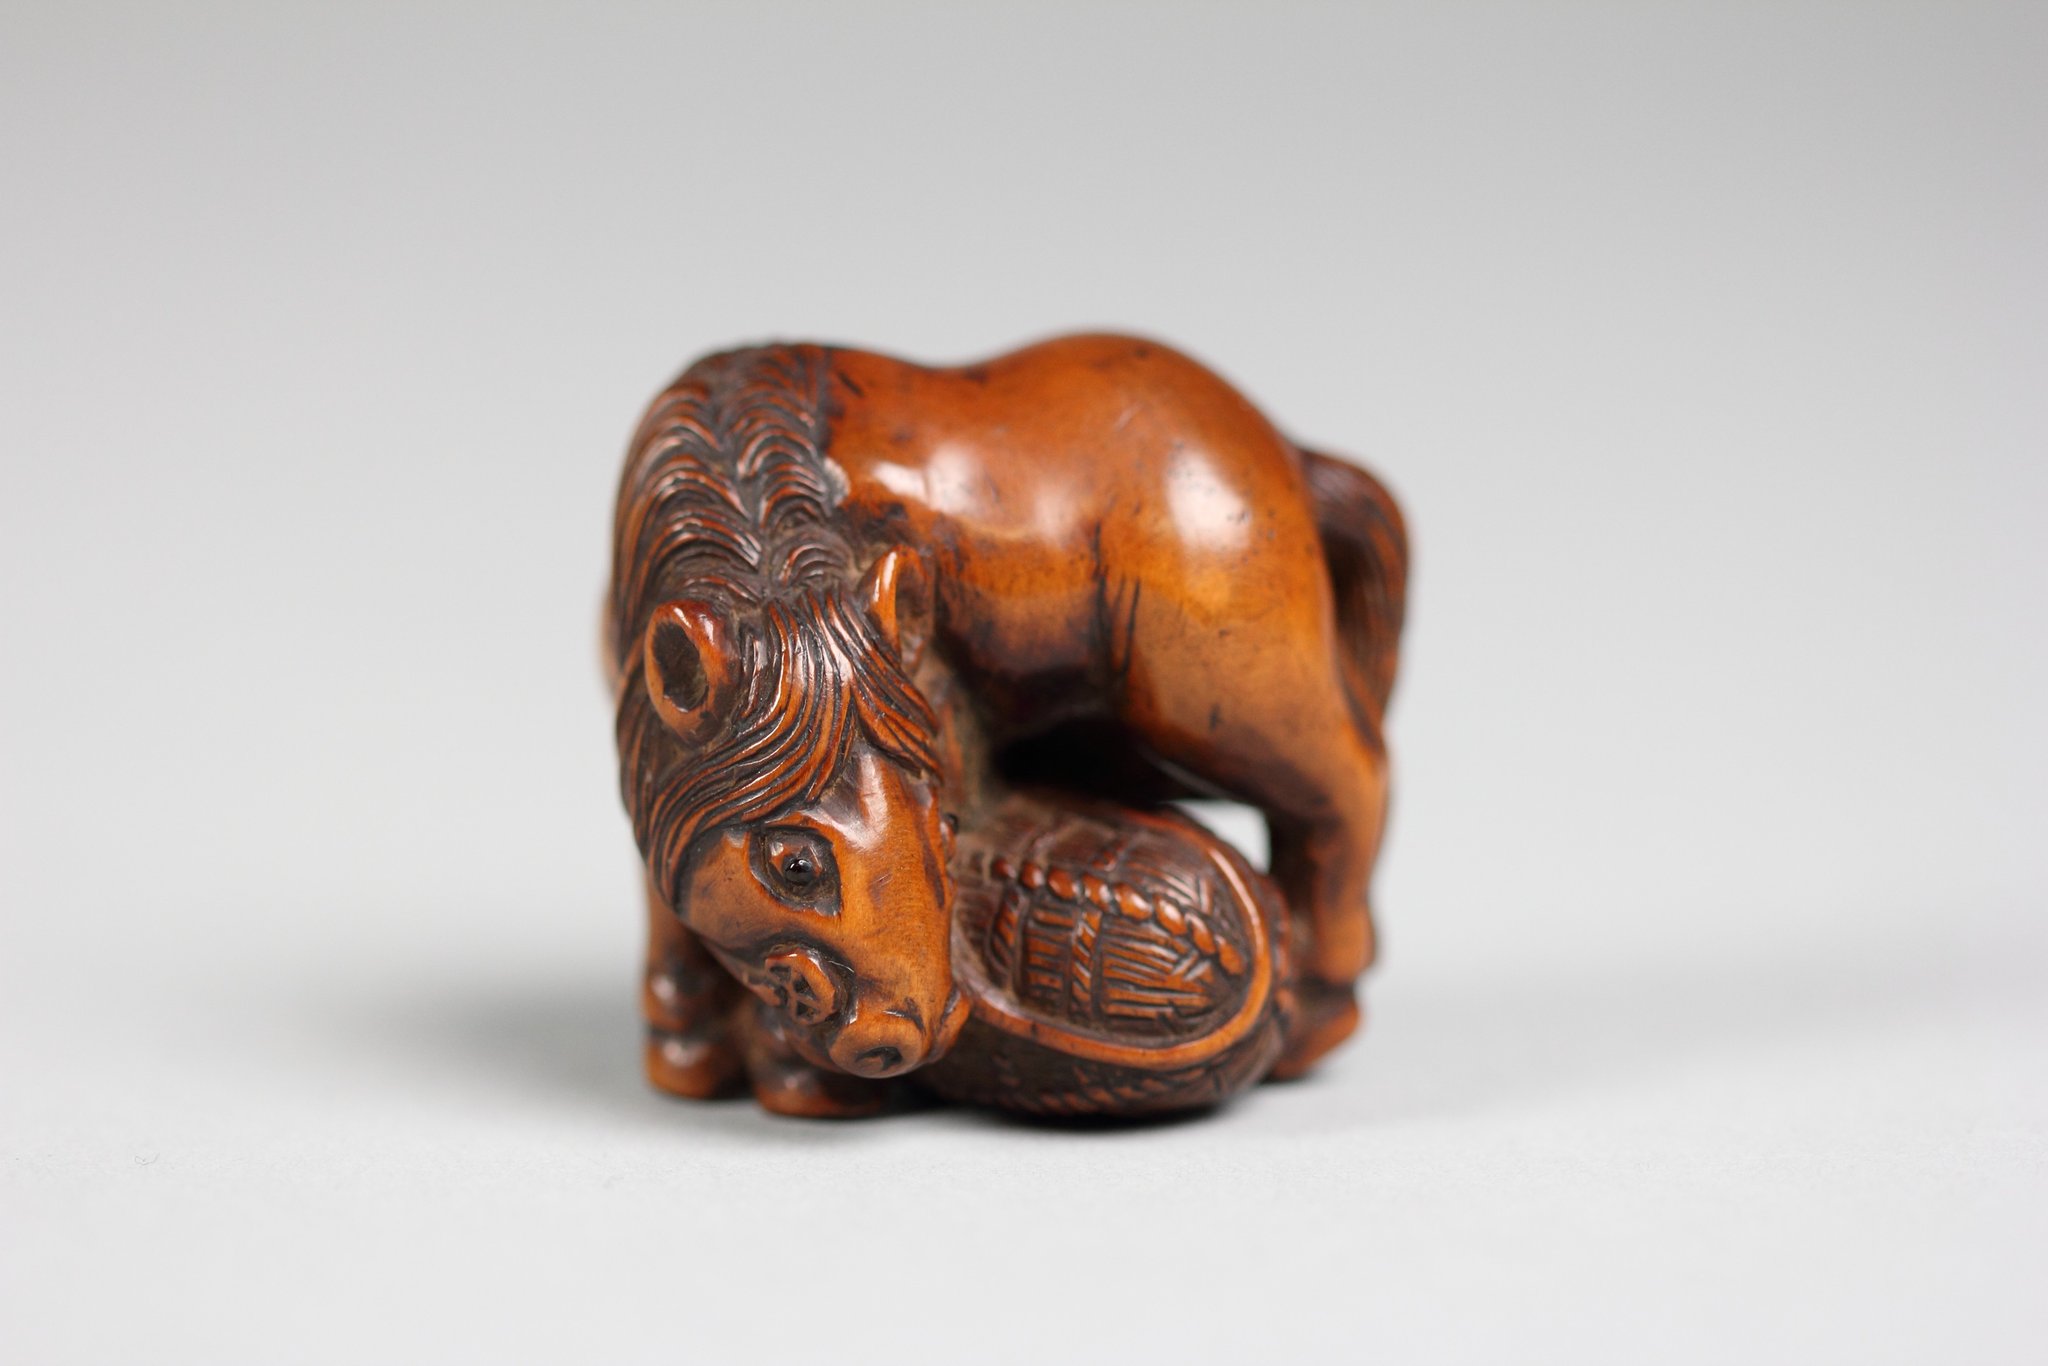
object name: netsuke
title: Netsuke of Horse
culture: japanese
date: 1701-1800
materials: wood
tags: horses